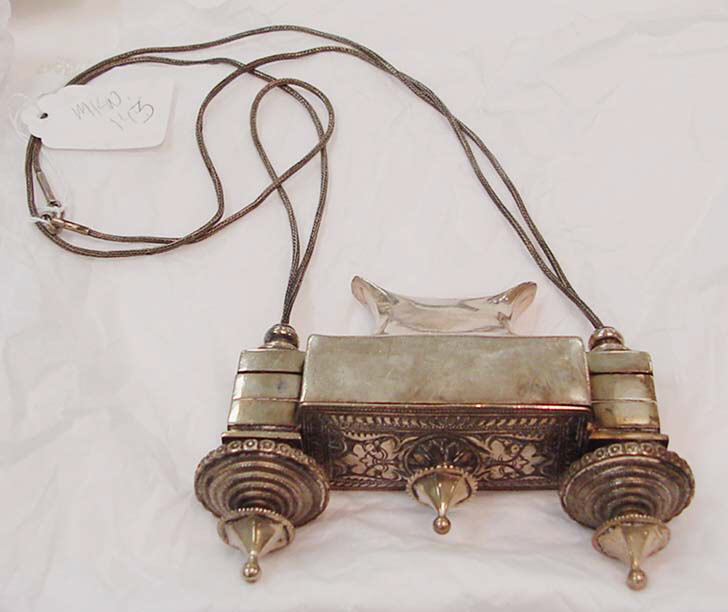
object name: necklace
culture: indian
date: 1867-1900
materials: metal